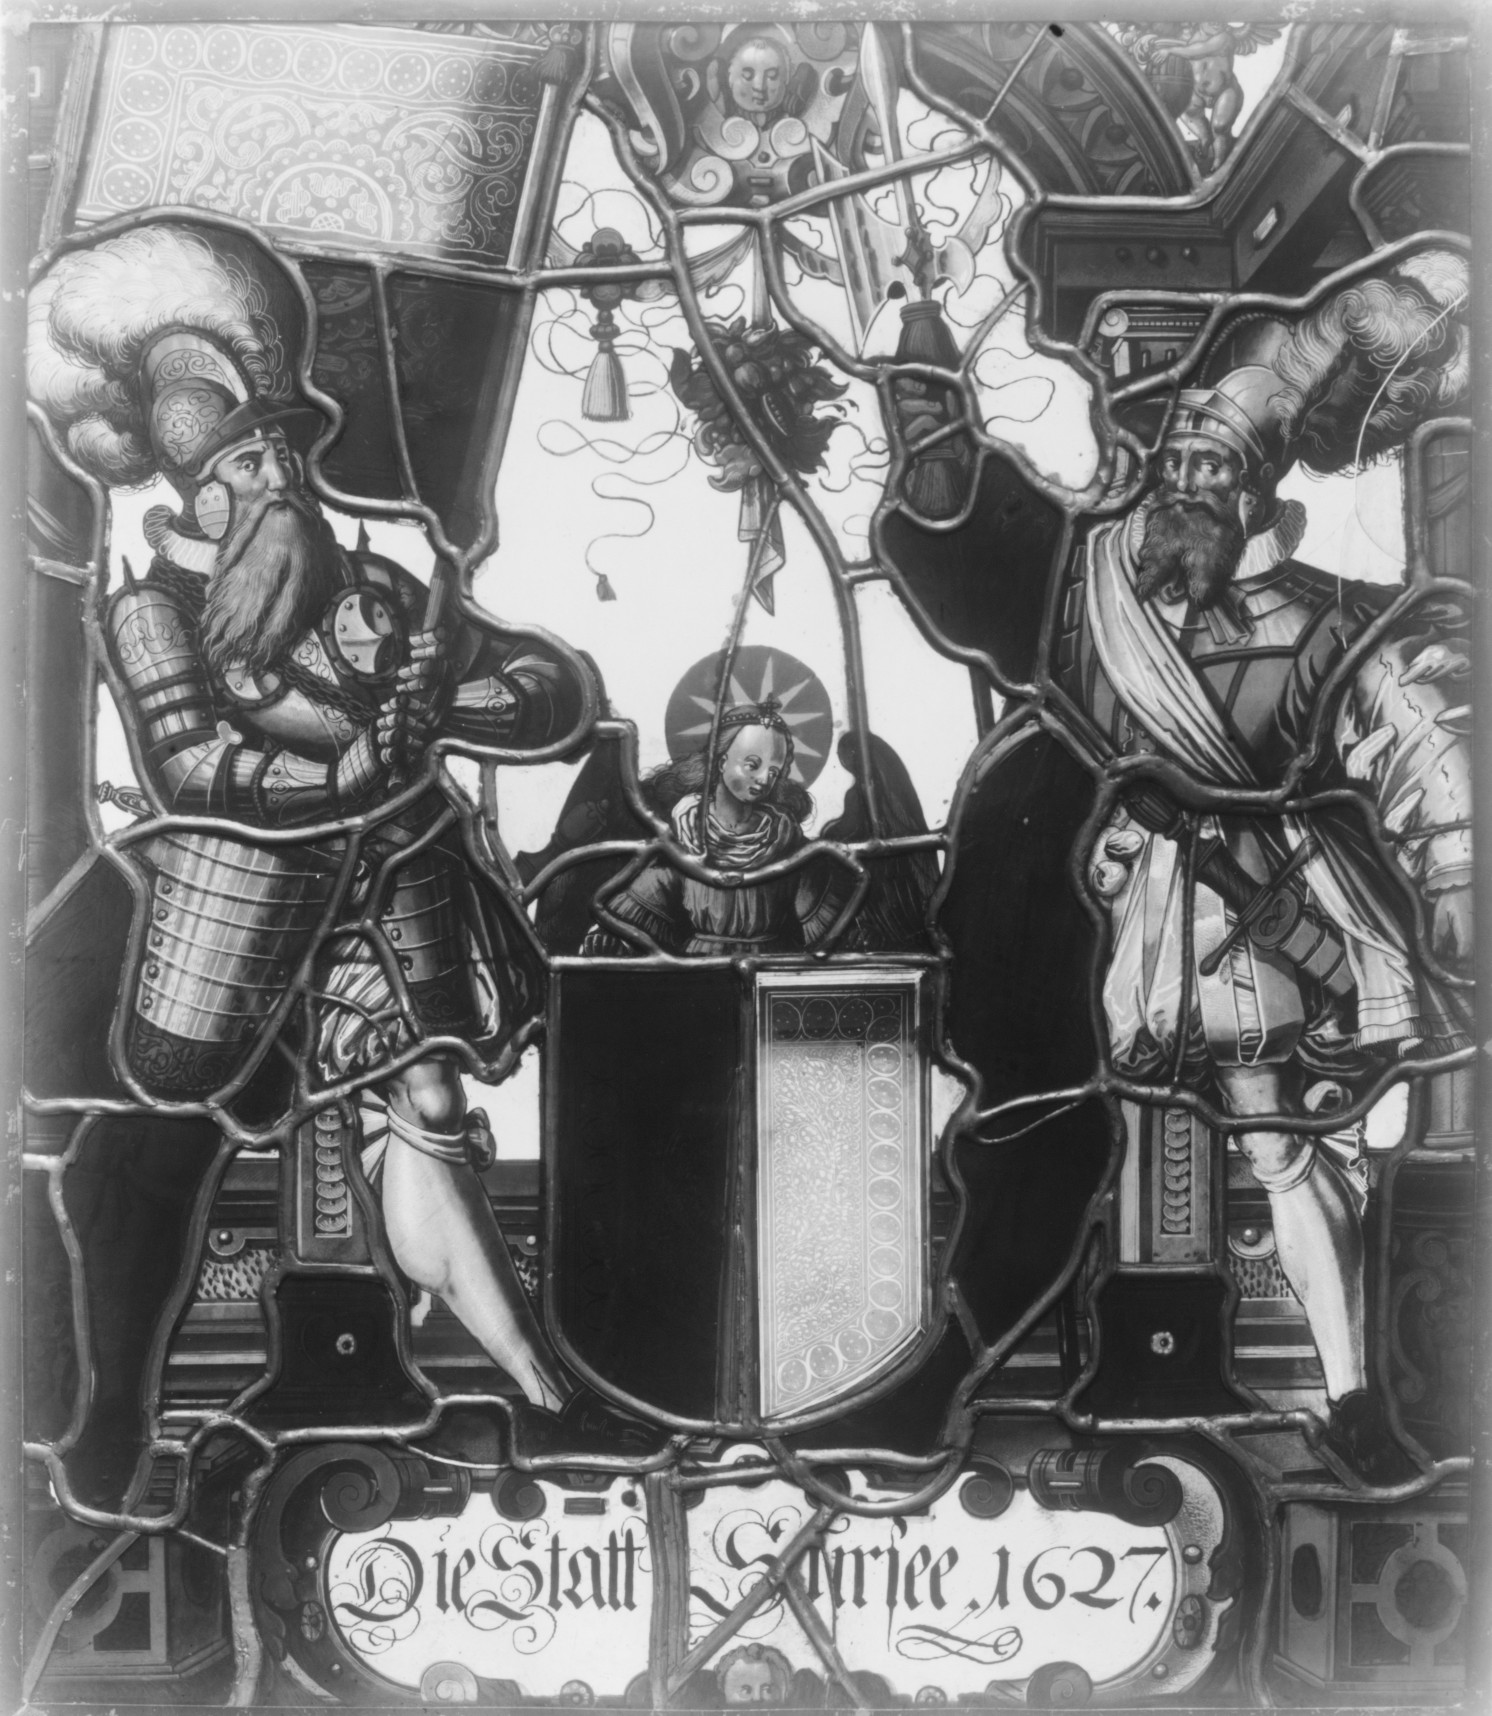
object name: panel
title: Arms of the city of Sursee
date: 1627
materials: glass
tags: coat of arms